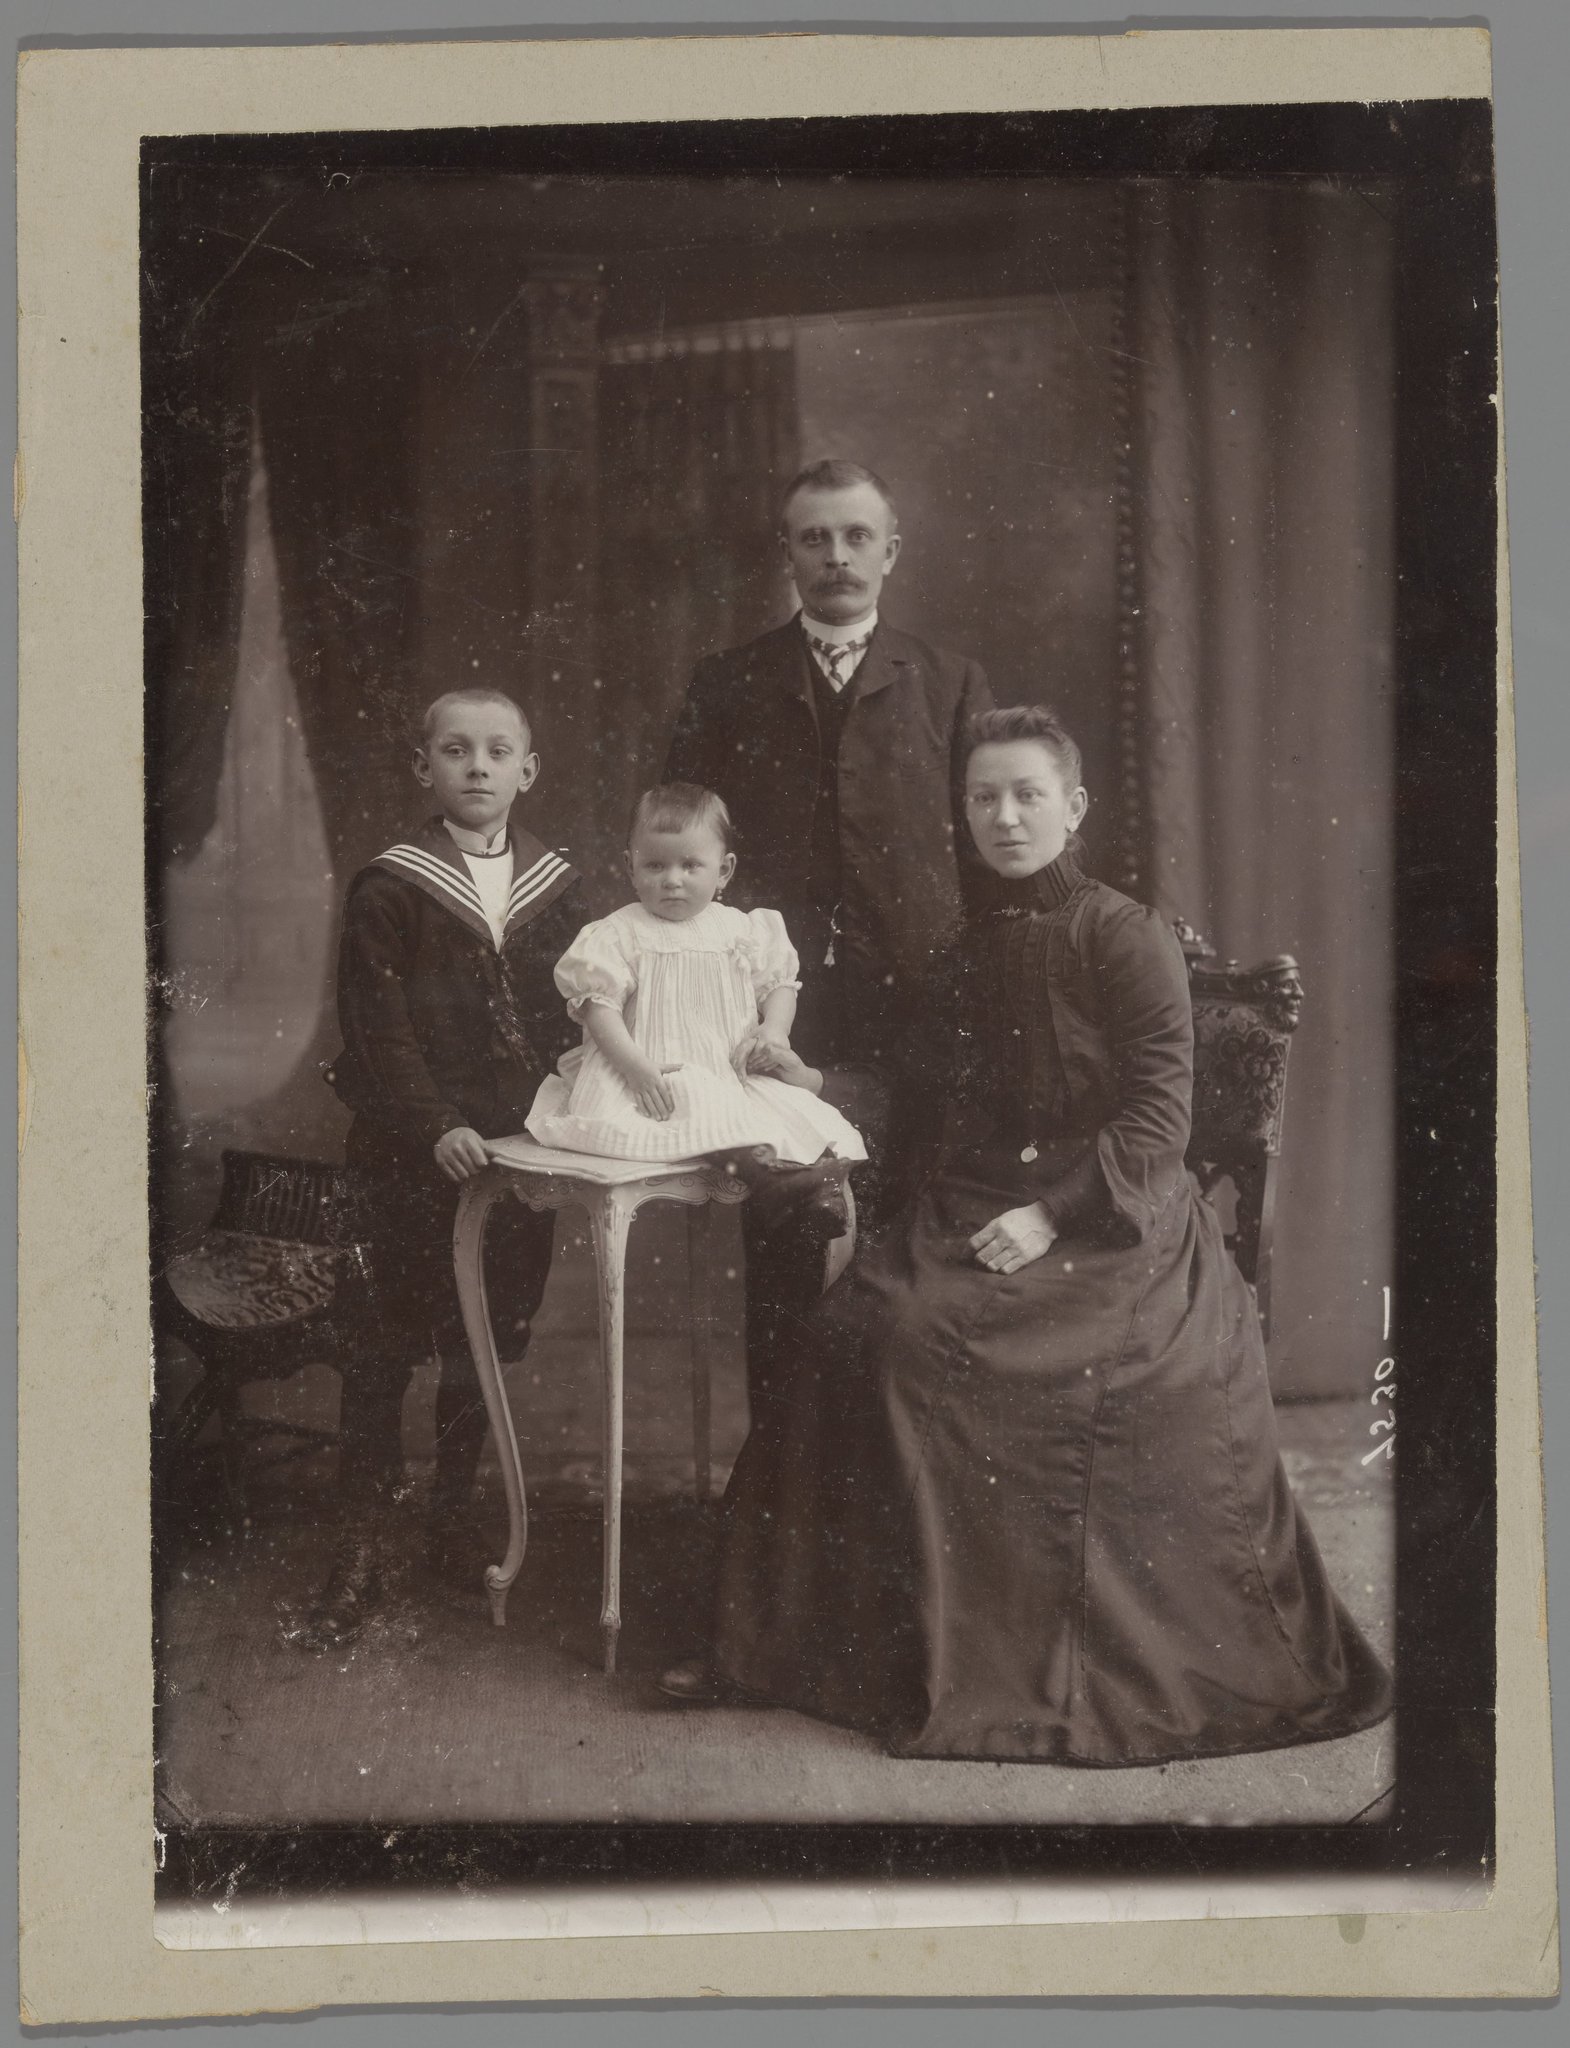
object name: photograph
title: Studioportret van een man, een vrouw en twee kinderen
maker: Anonymous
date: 1874-1900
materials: cardboard, photographic support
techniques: albumen print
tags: family group, especially parents with their child(ren)